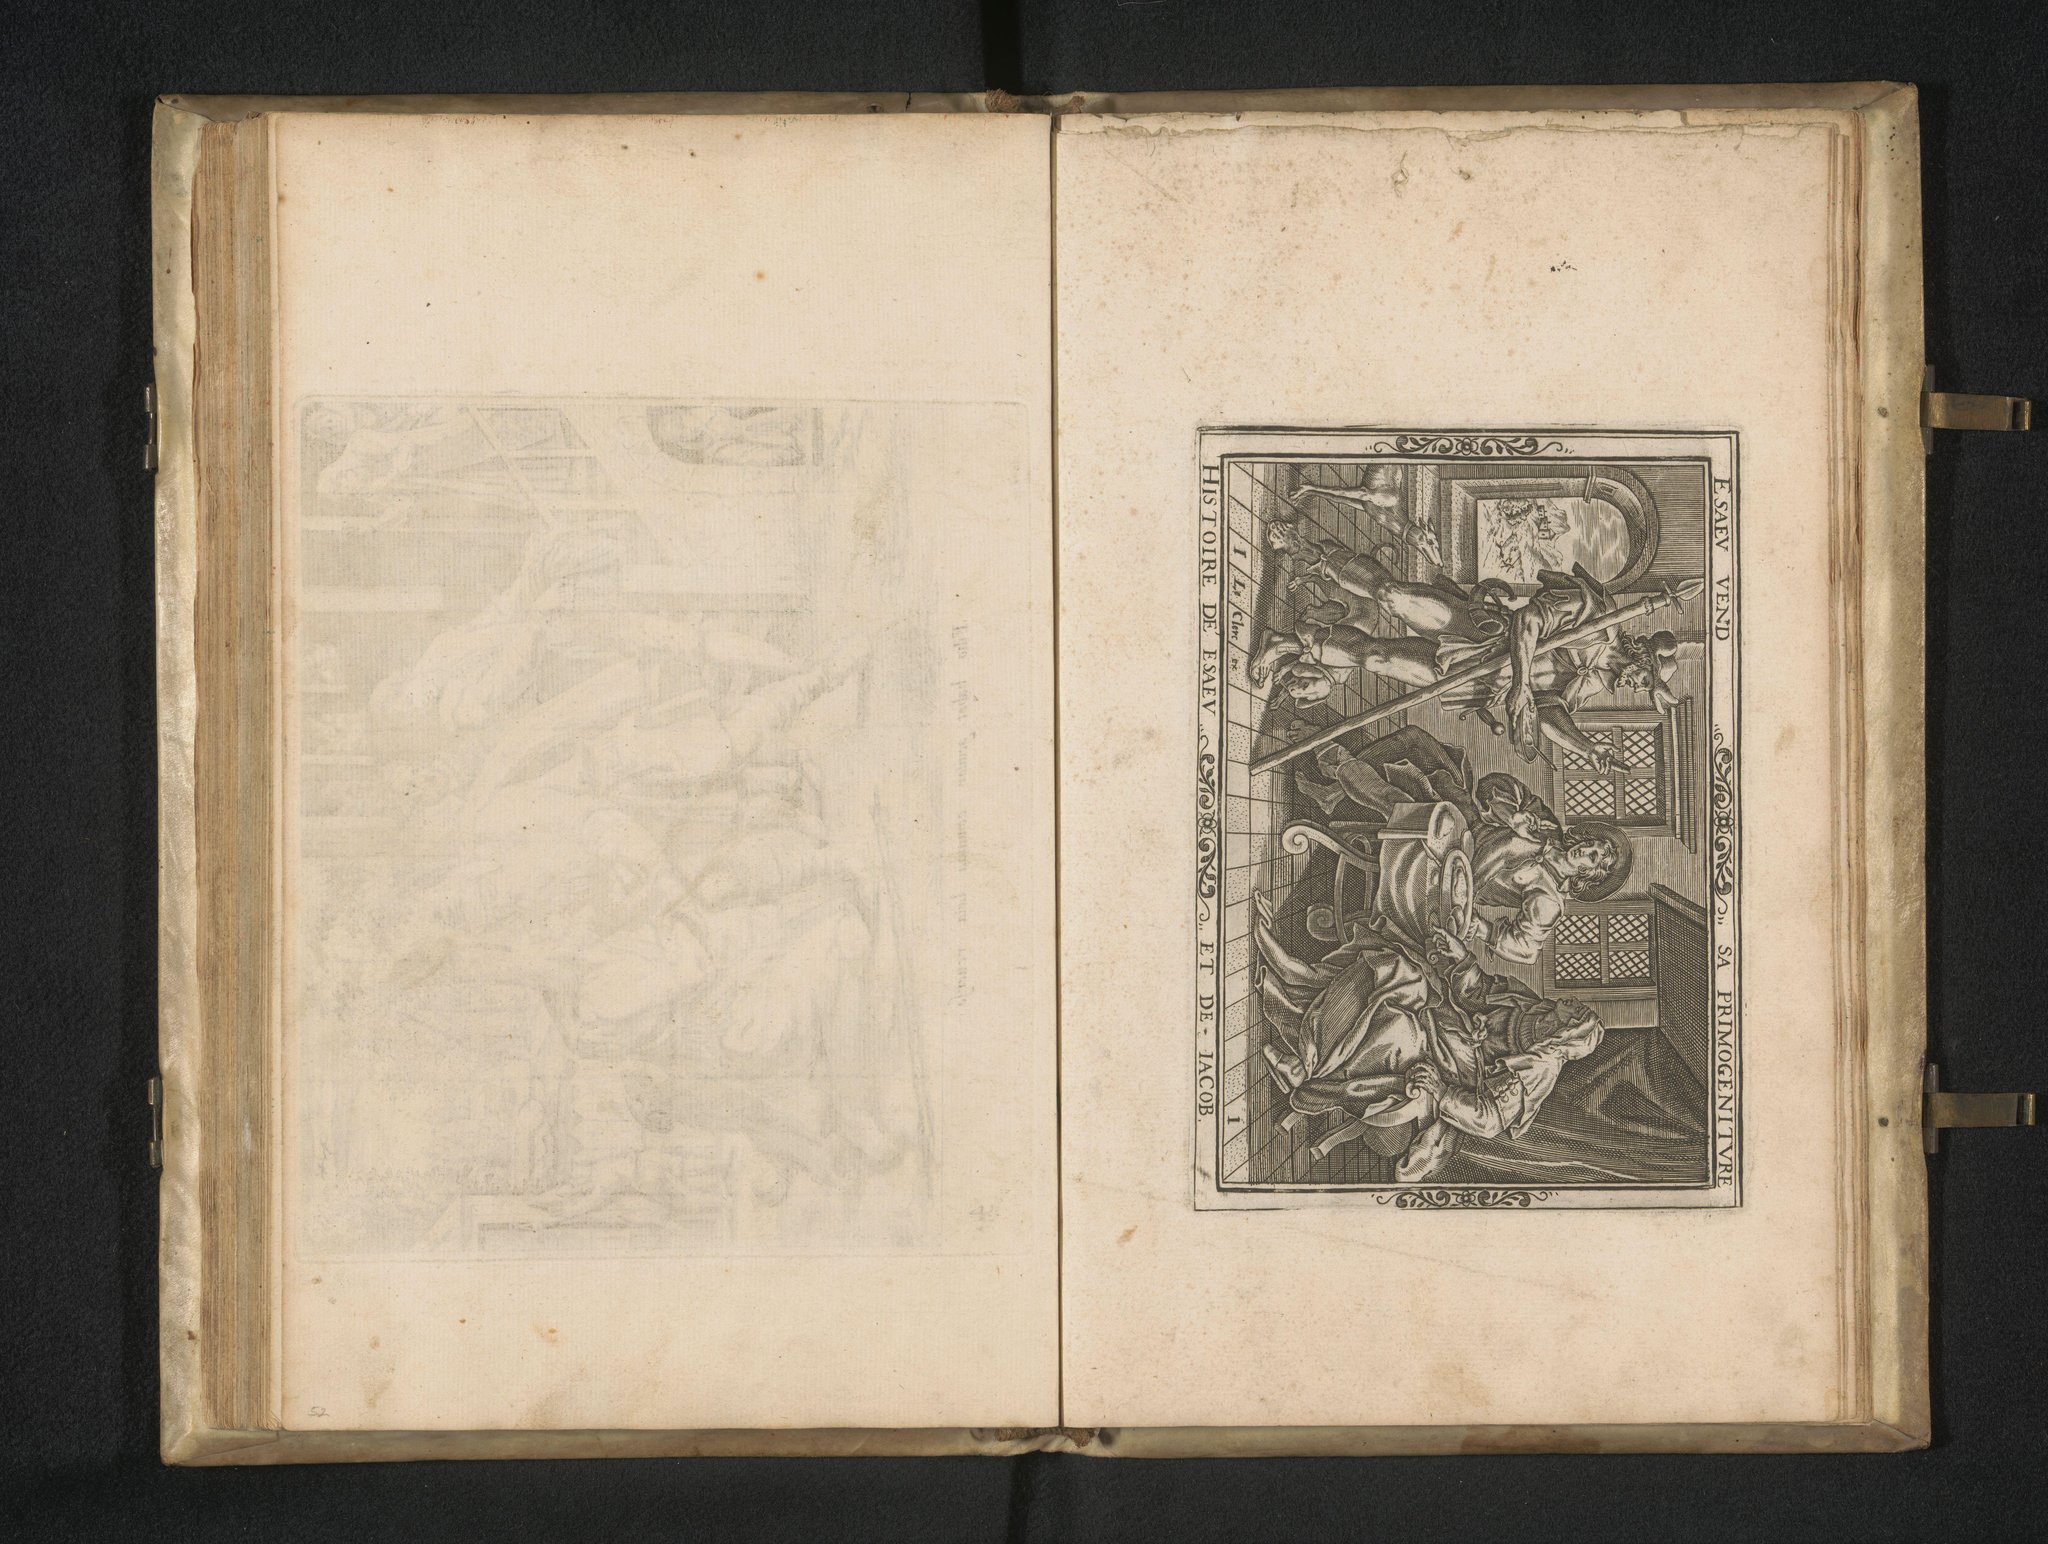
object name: print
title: Esau verkoopt zijn eerstgeboorterecht aan Jakob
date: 1580-1621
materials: paper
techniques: engraving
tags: esau, returning hungry from the hunt, sells his first birthright to jacob for a pottage of lentils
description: Esau is hongerig teruggekeerd van de jacht. Zijn jachthonden staan naast hem. Hij verkoopt zijn eerstgeboorterecht aan zijn jongere broer Jakob voor een bord linzen, dat hij al in zijn handen heeft. Jakob en Rebekka zitten aan tafel. Onderdeel van een serie van 4 prenten van de geschiedenis van Jakob en Esau. Genummerd rechtsonder: 1. Onderdeel van een album met voornamelijk christelijke voorstellingen.